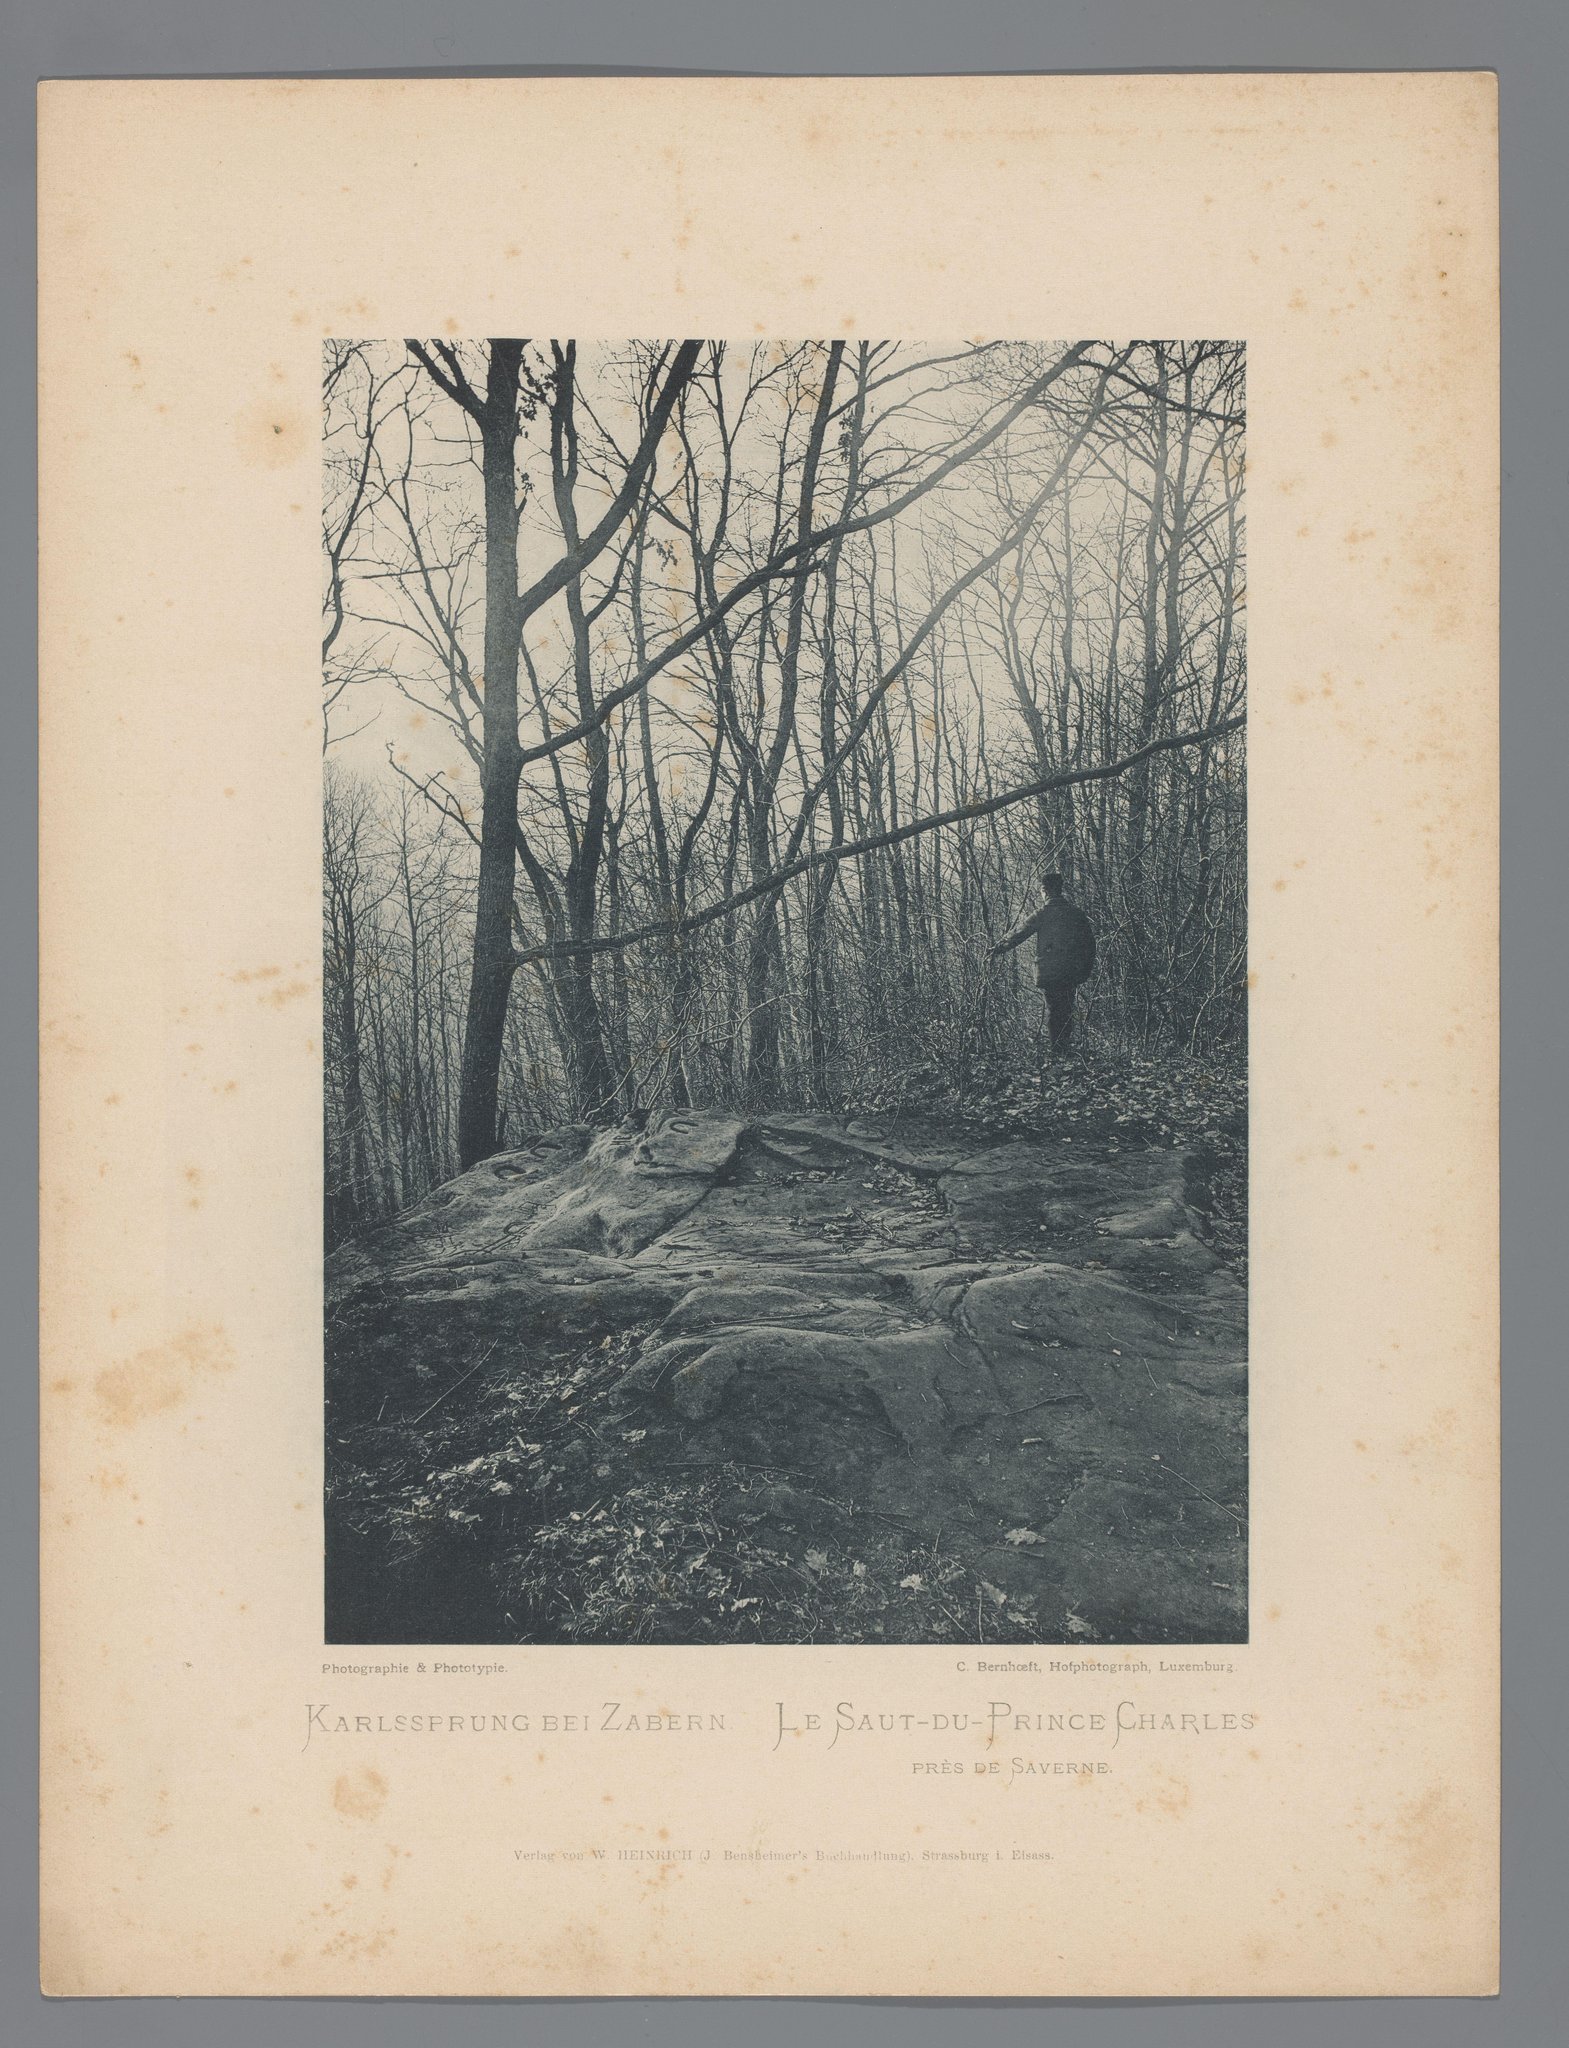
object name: page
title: Karlssprung bei Zabern, Le Saut-du-Prince Charles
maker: charles bernhoeft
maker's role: publisher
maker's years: 1859-1933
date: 1889-1894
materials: paper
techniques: photograph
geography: luxembourg city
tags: rock-formations, forest, wood (+ landscape with figures, staffage)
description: Deze prent maakt deel uit van een omslag met 100 prenten.